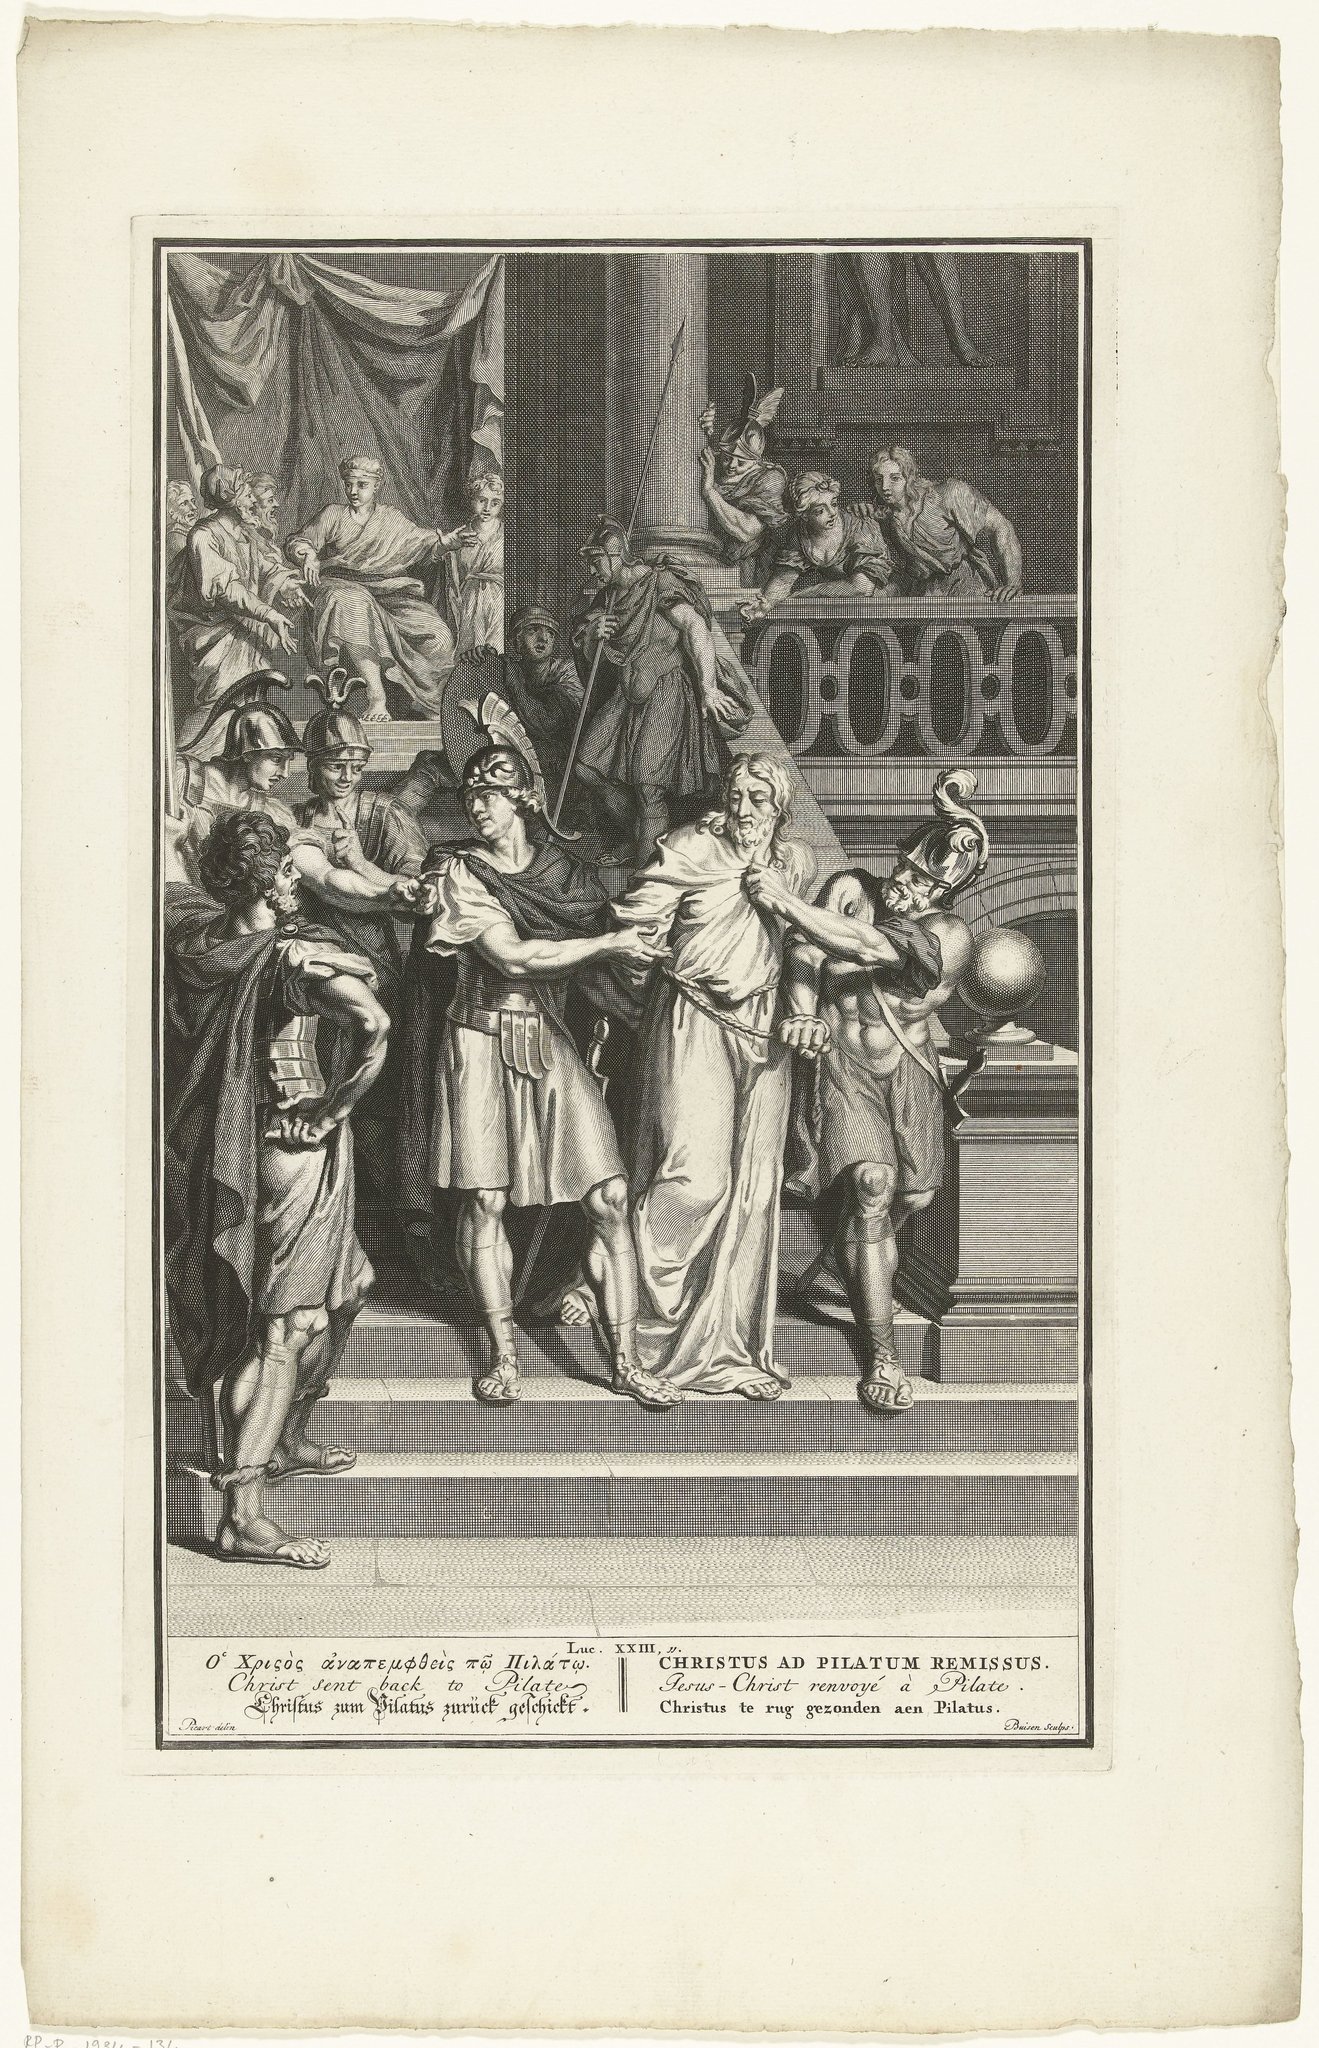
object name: print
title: Christus te rug gezonden aen Pilatus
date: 1711-1720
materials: paper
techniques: engraving, etching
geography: amsterdam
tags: christ brought from one judge to another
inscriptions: collector's mark: ‘Utrechts Fundatie Huys’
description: Christus werd voorgeleid aan keizer Herodes. Omdat hij op geen van diens vragen antwoord wordt hij teruggestuurd naar Pilatus. Illustratie voor het Nieuwe Testament, Luc. 23, 11. Onder de voorstelling een titel in het Grieks, Engels, Duits, Latijn, Frans en Nederlands.